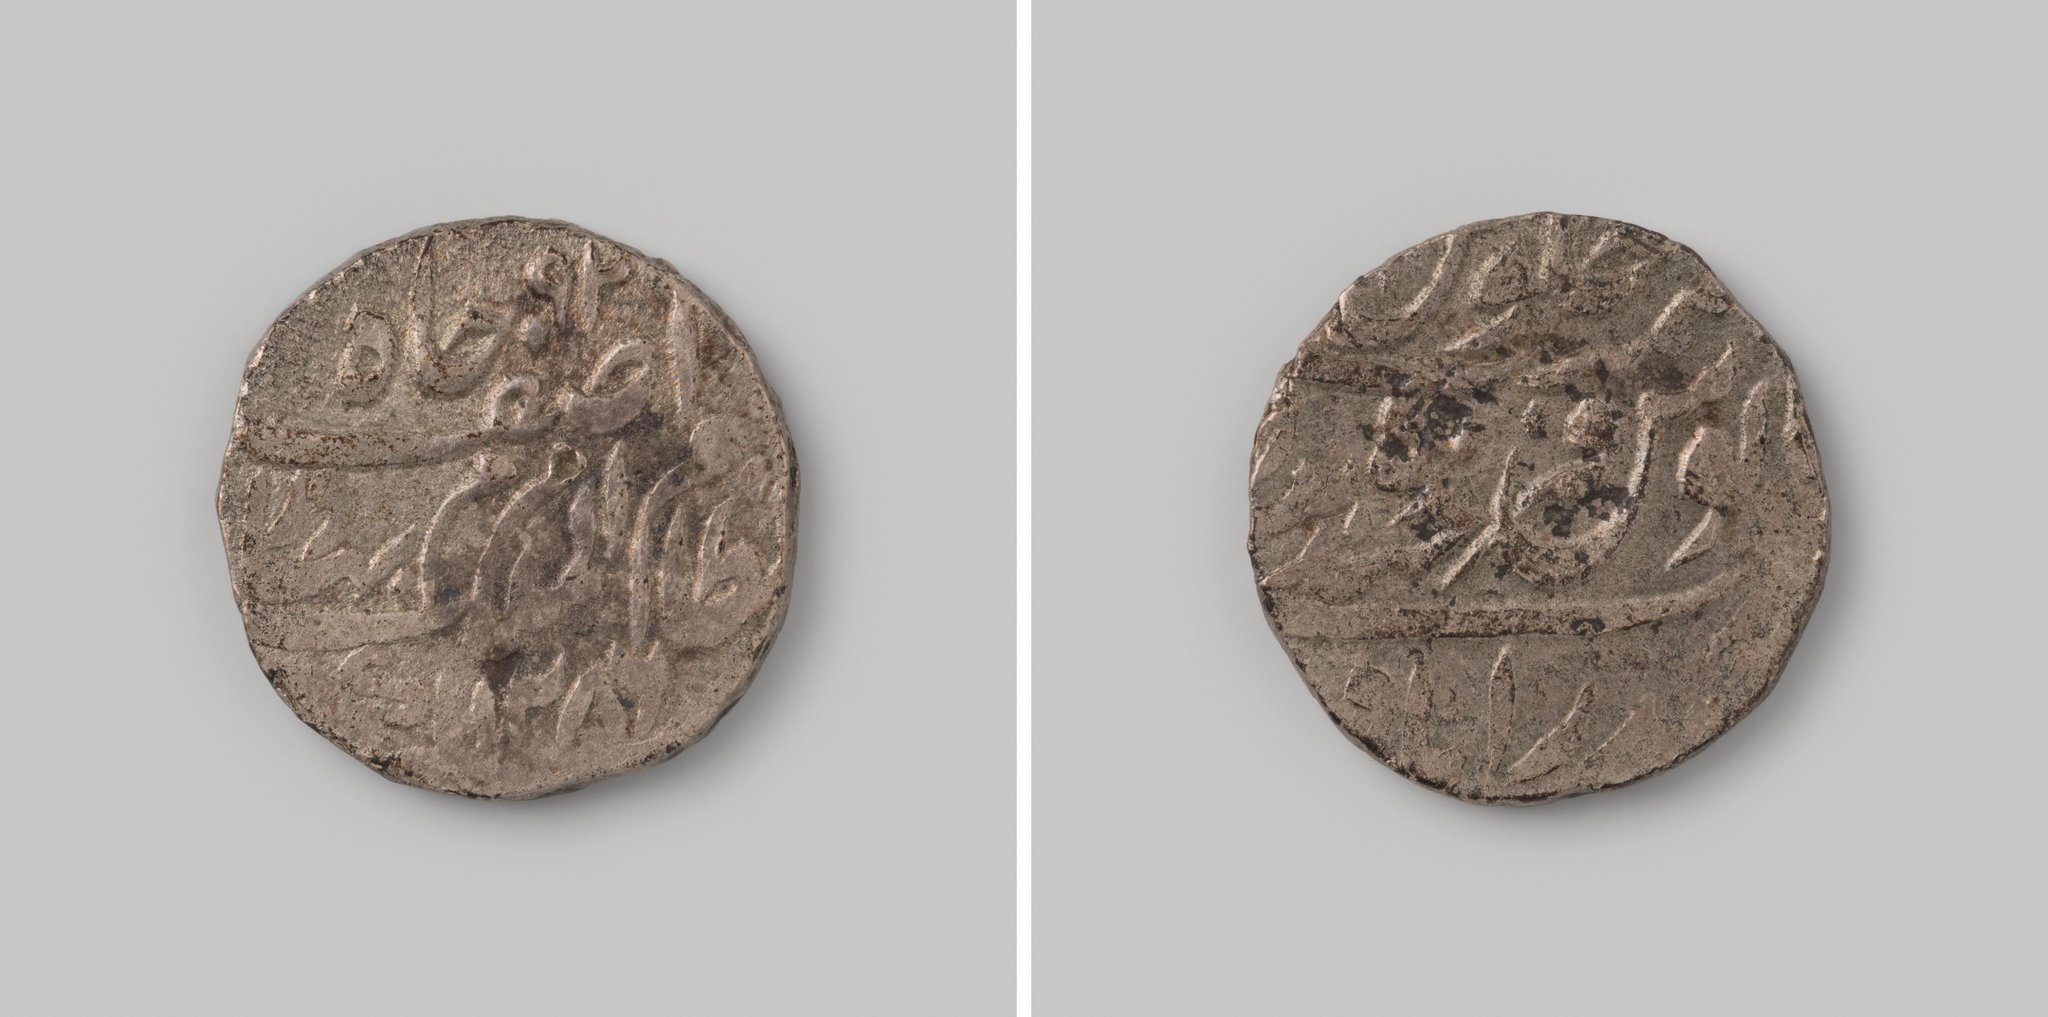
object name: coin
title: ½ roepie uit Hyderabad in India van Afzal-ad-daula, 1284 [=1862]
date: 1862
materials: silver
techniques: striking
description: Zilveren munt. Voorzijde: in Arabische lettertekens opschrift met naam van de sjah. Keerzijde: in Arabische lettertekens opschrift met jaartal-aanduiding.